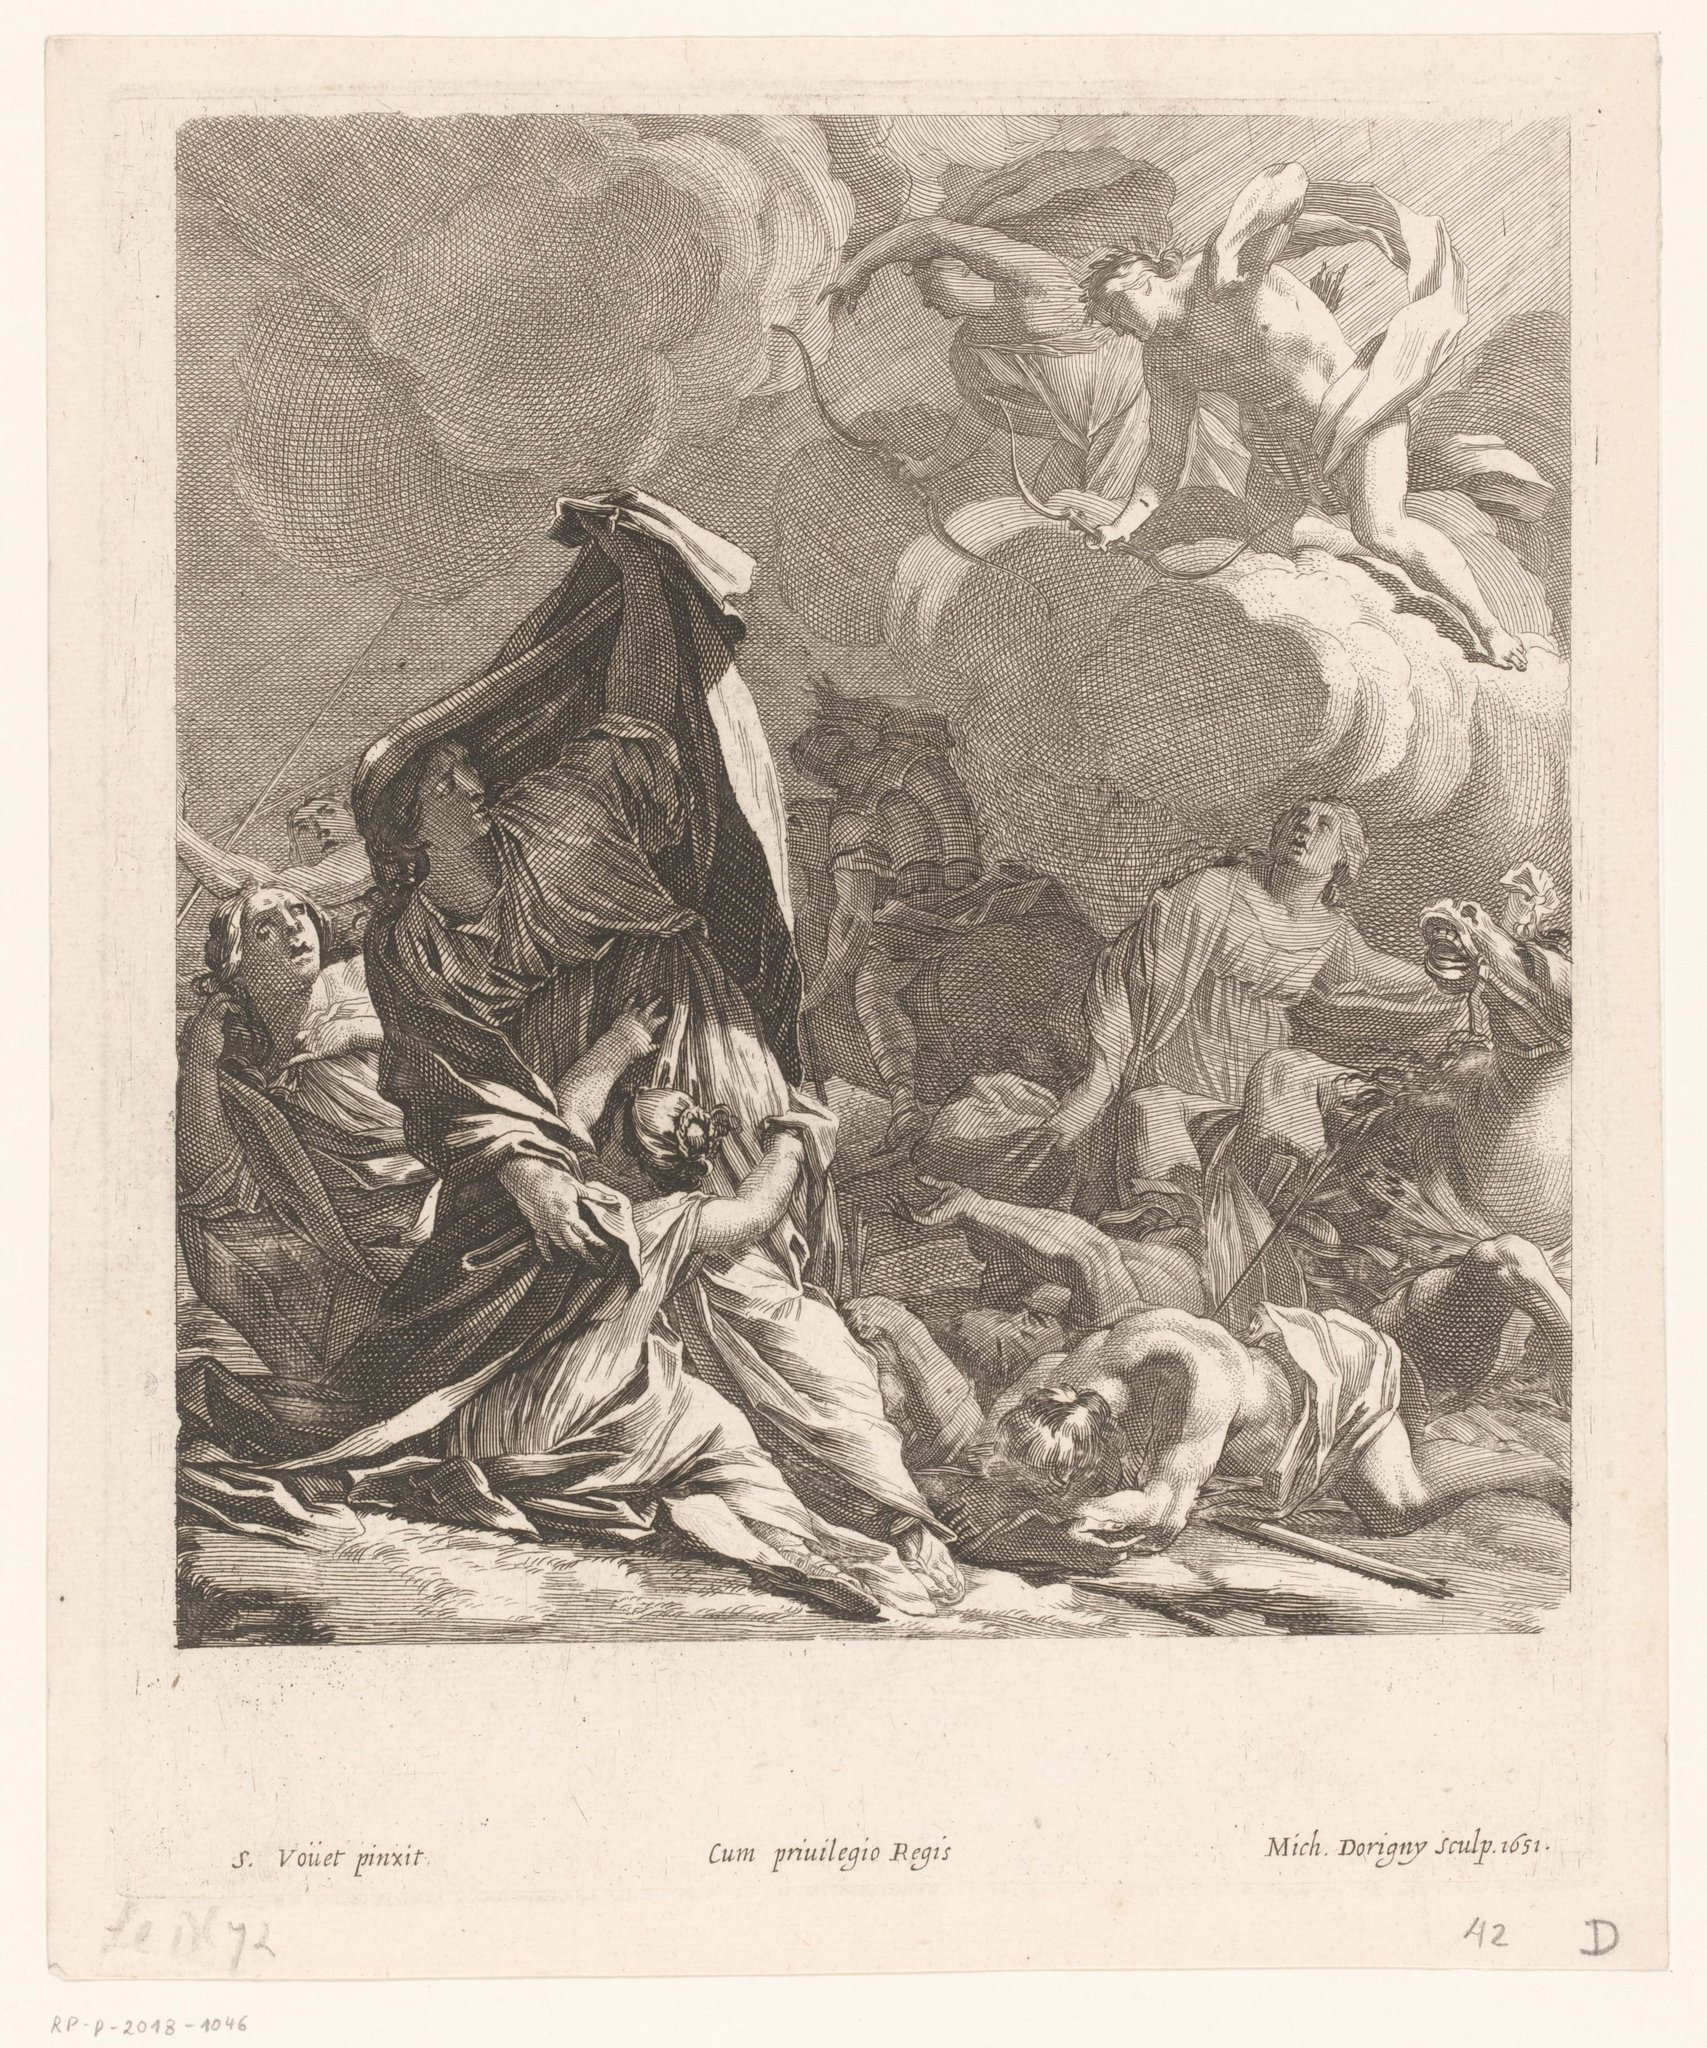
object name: print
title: Dood van Niobes kinderen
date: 1651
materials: paper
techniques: engraving, etching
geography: france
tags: apollo and diana kill niobe's children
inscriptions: collector's mark: Lugt 2228